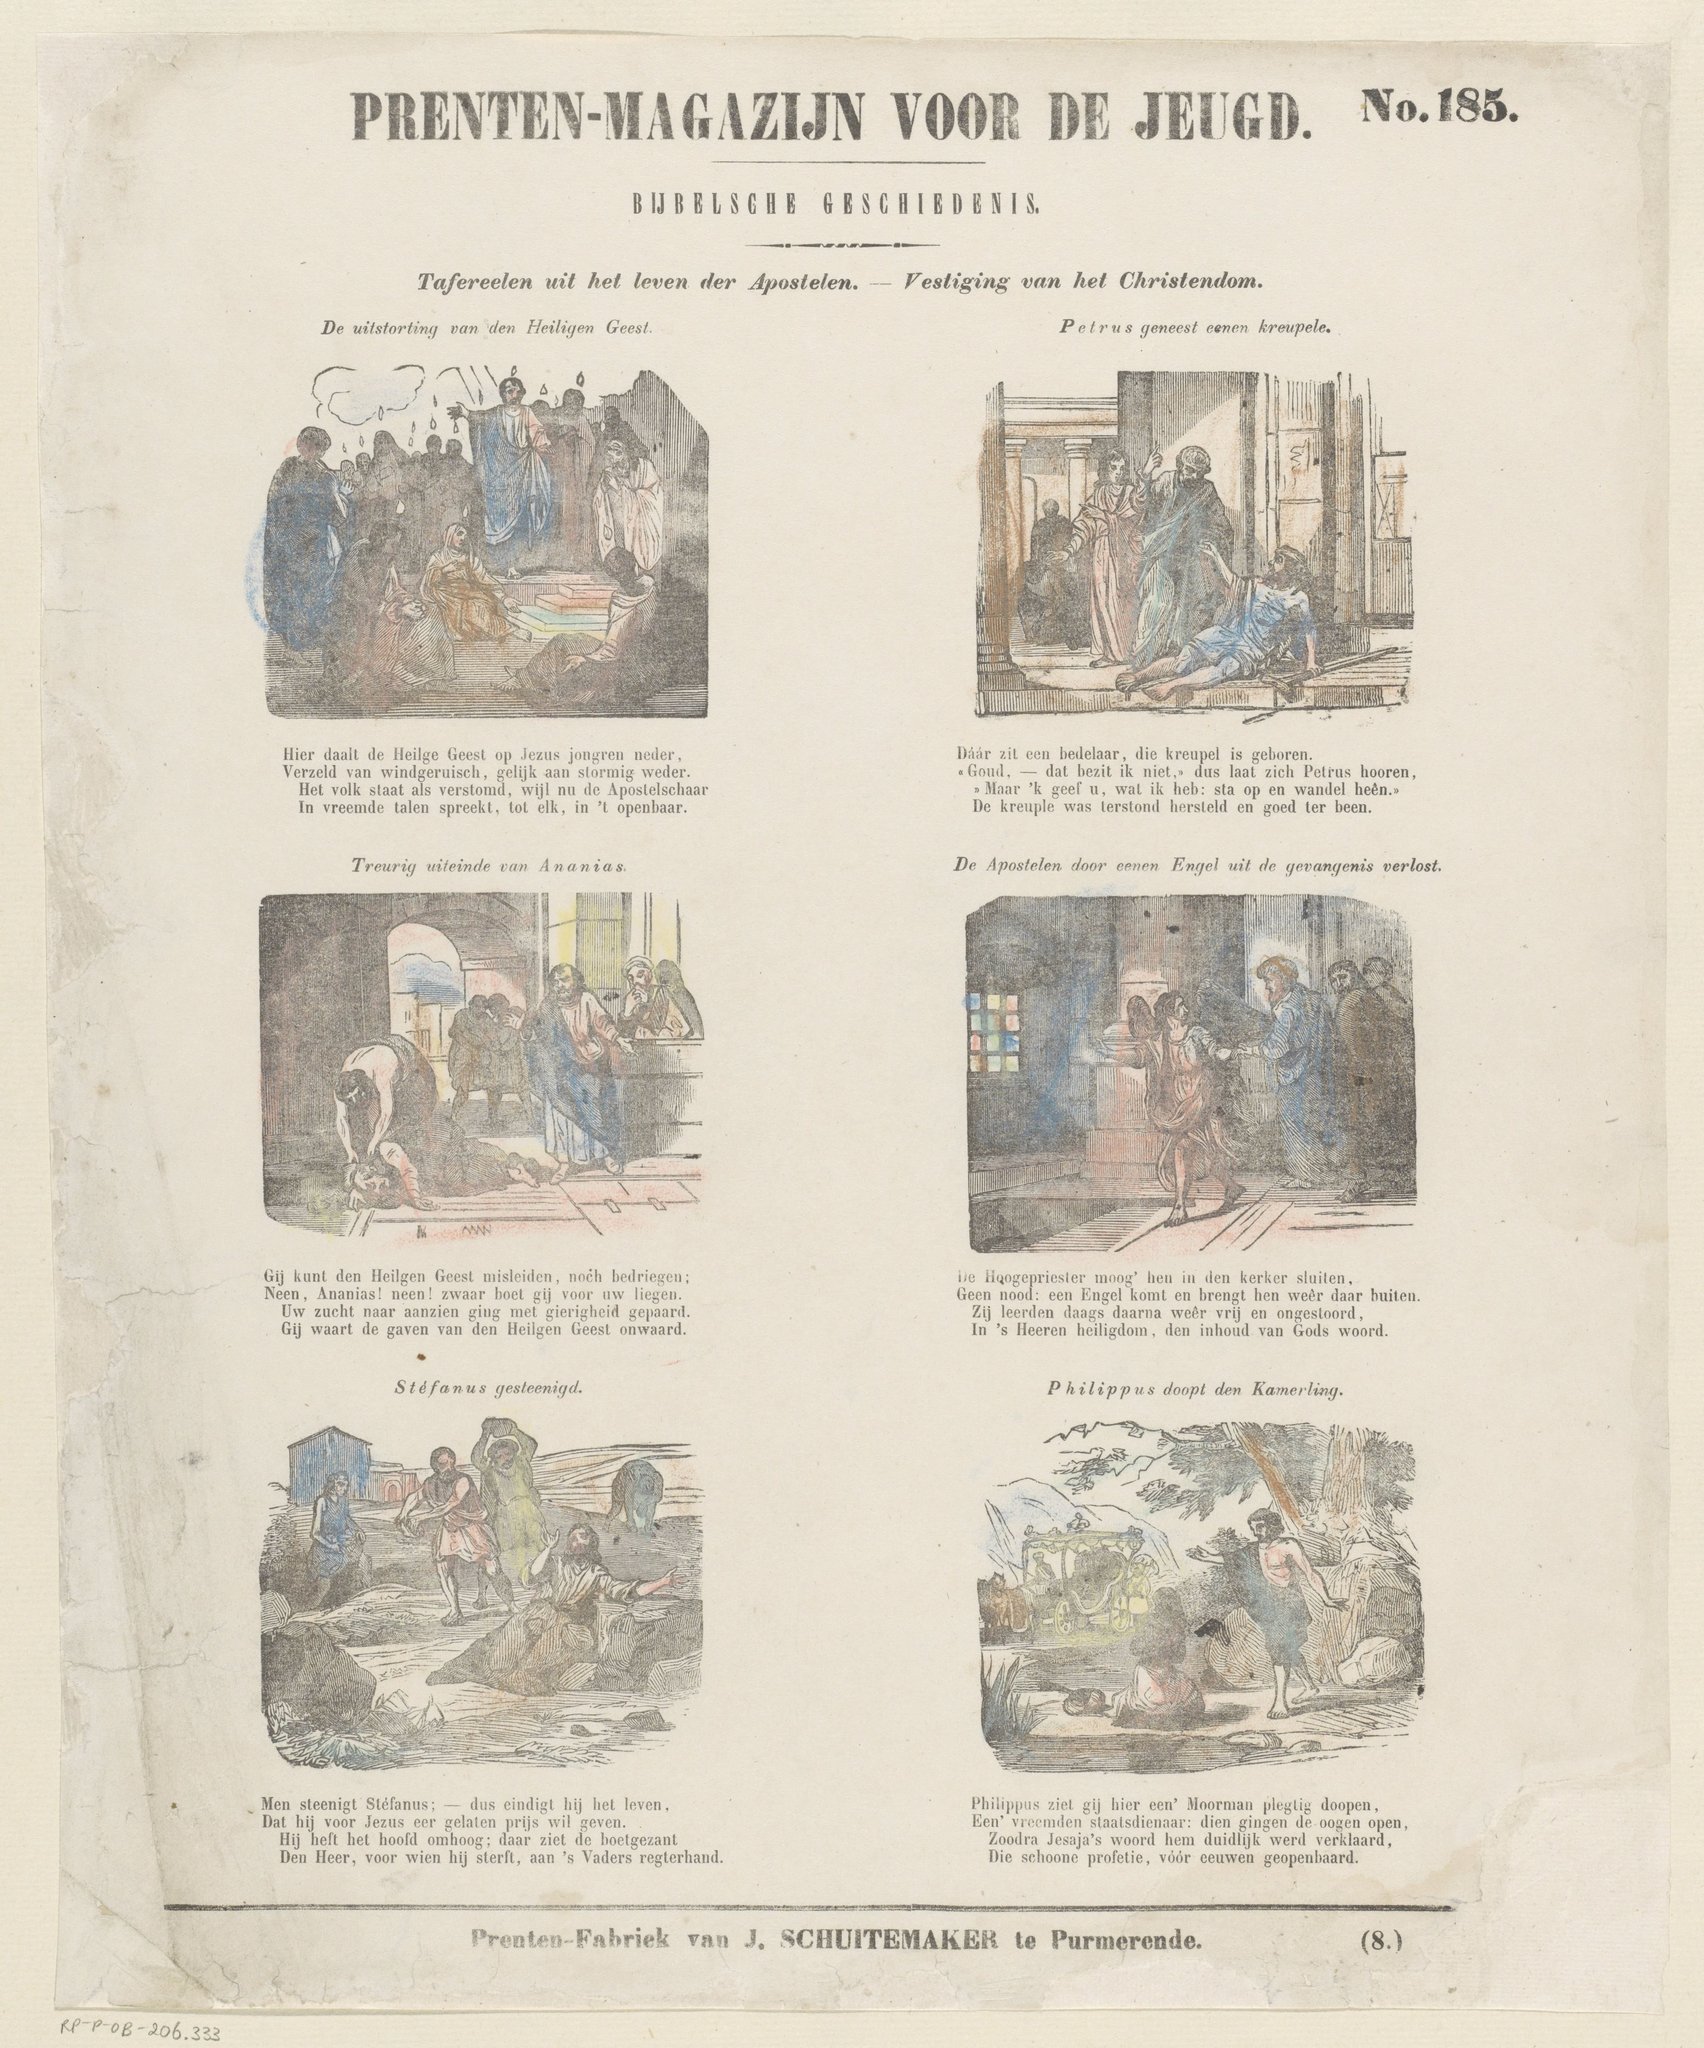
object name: print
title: Prenten-magazijn voor de jeugd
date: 1850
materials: paper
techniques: colour, letterpress printing, engraving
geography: netherlands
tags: lives and acts of the apostles (part ii), lives and acts of the apostles (part i)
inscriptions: collector's mark: Lugt 2760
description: Na voltooiing van de acht jaargangen van de reeks 'Prenten-magazijn voor de jeugd' in 1850 heeft Jan Schuitemaker al deze prenten heruitgegeven en omgenummerd als nr. 1 t/m 192. De oorspronkelijke jaargang wordt telkens nog vermeld rechtsonder op de prent. Binnen de jaargangen zijn prenten van hetzelfde thema in clusters van vier achter elkaar gezet.